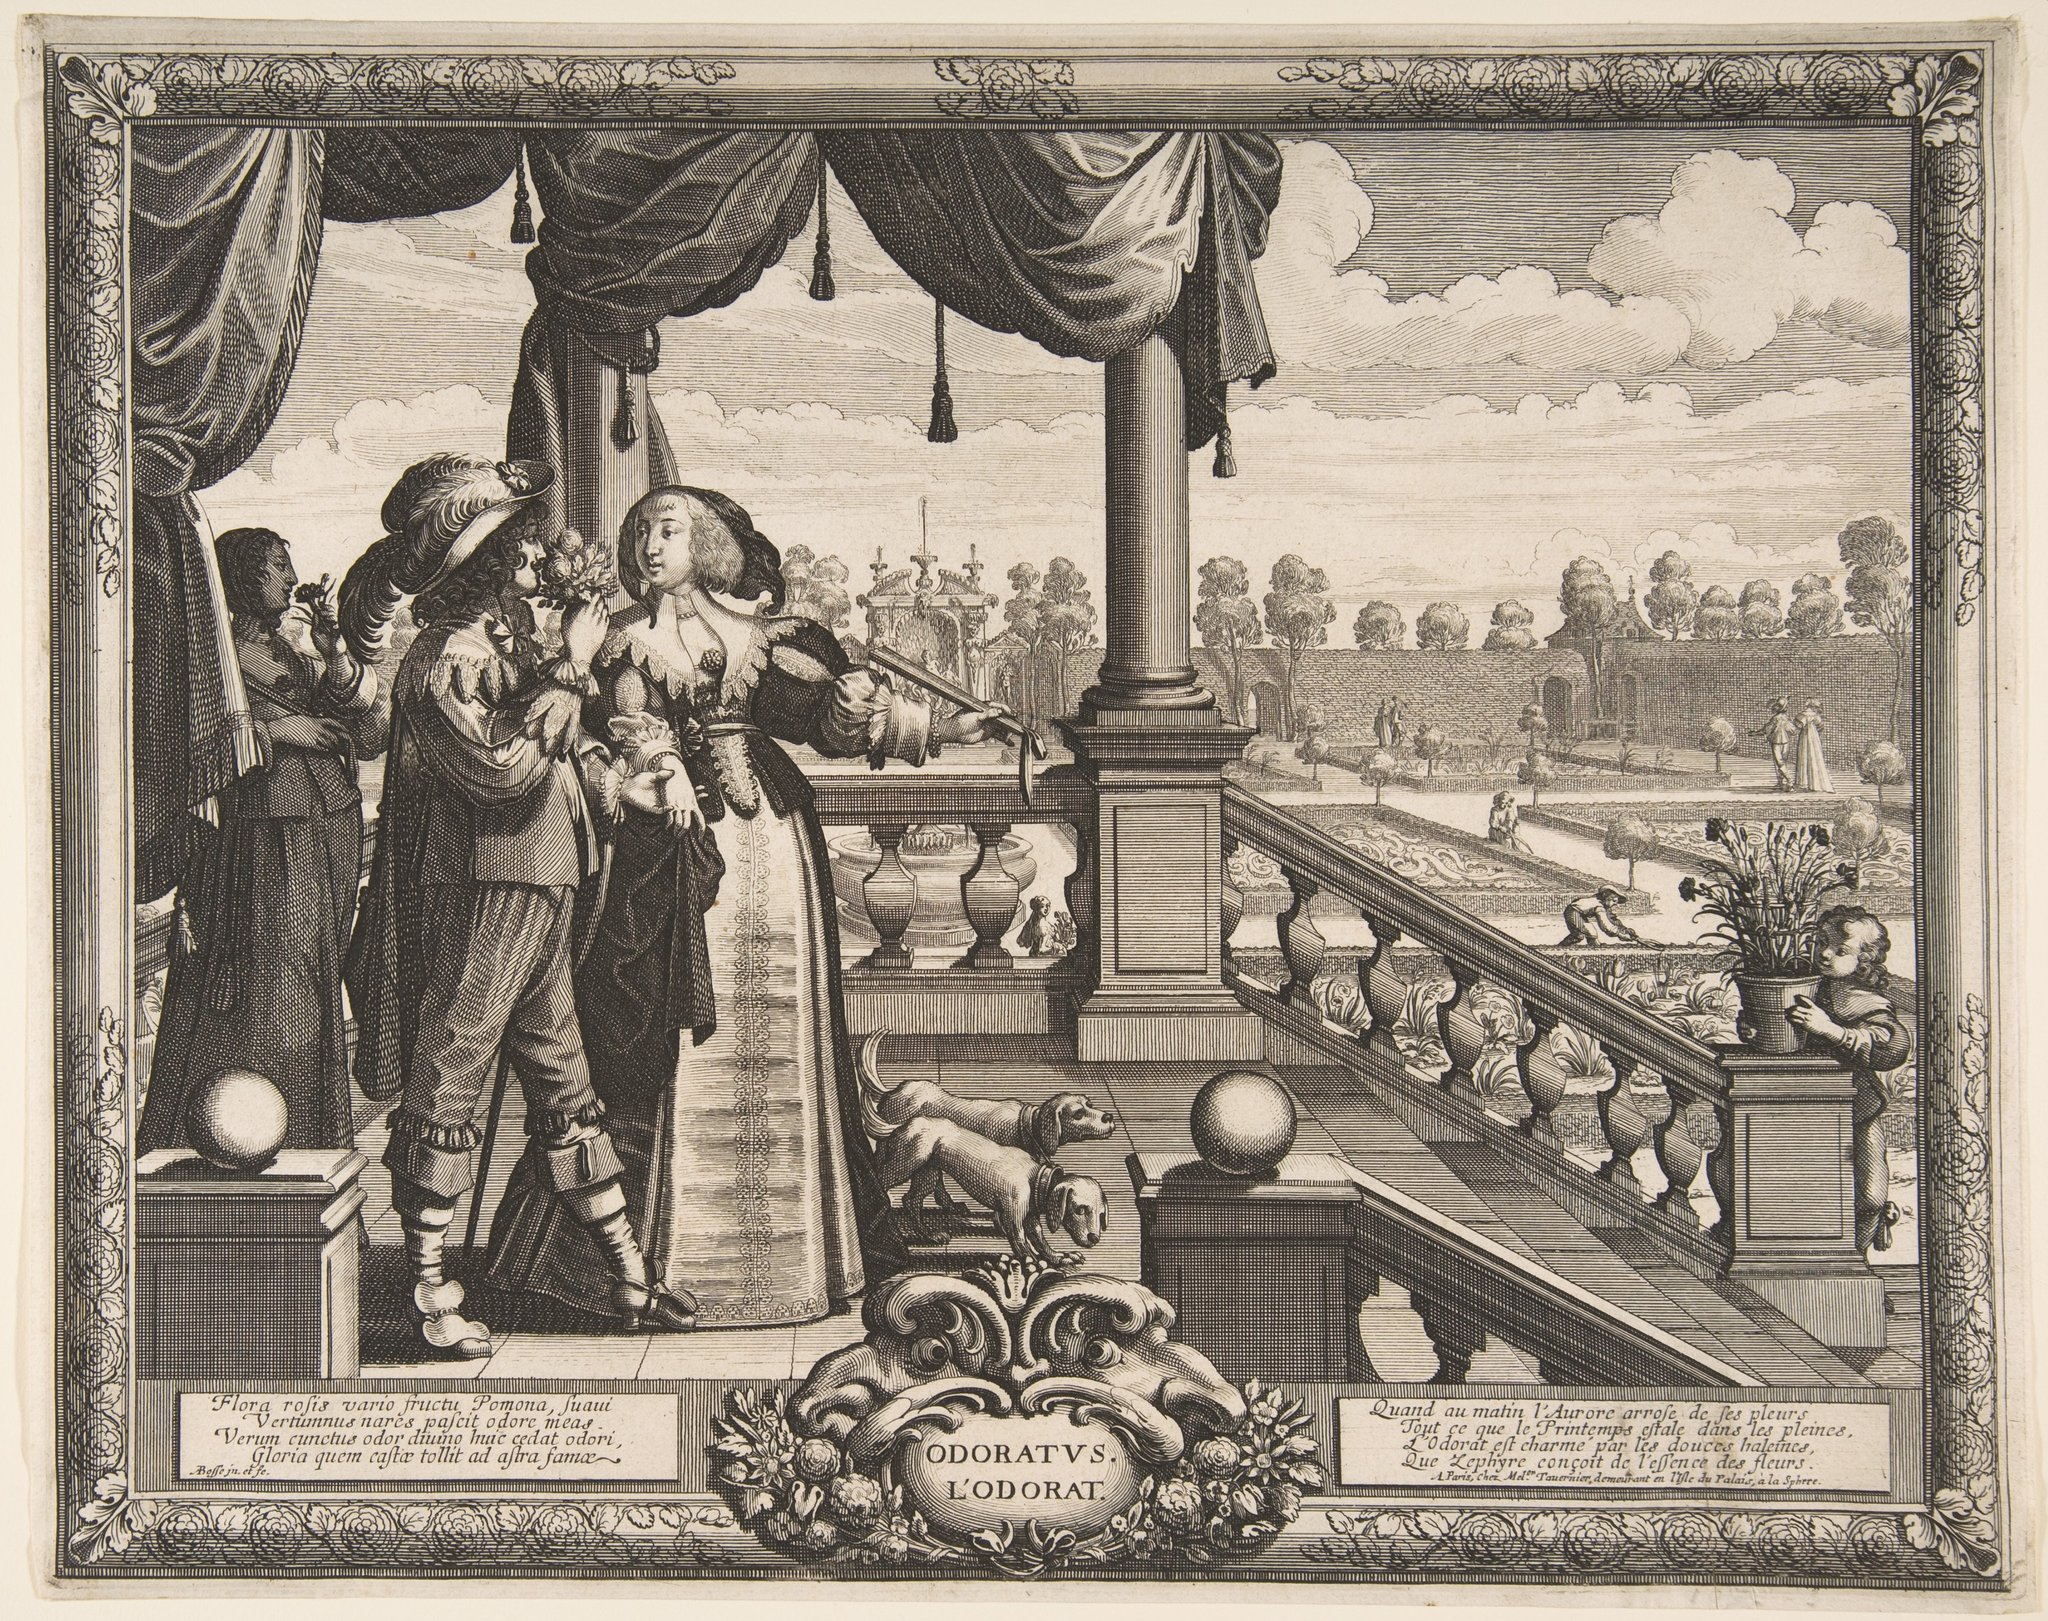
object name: print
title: Smell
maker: abraham bosse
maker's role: artist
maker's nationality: french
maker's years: 1602-1676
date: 1638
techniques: etching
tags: gardens,children,men,women,dogs